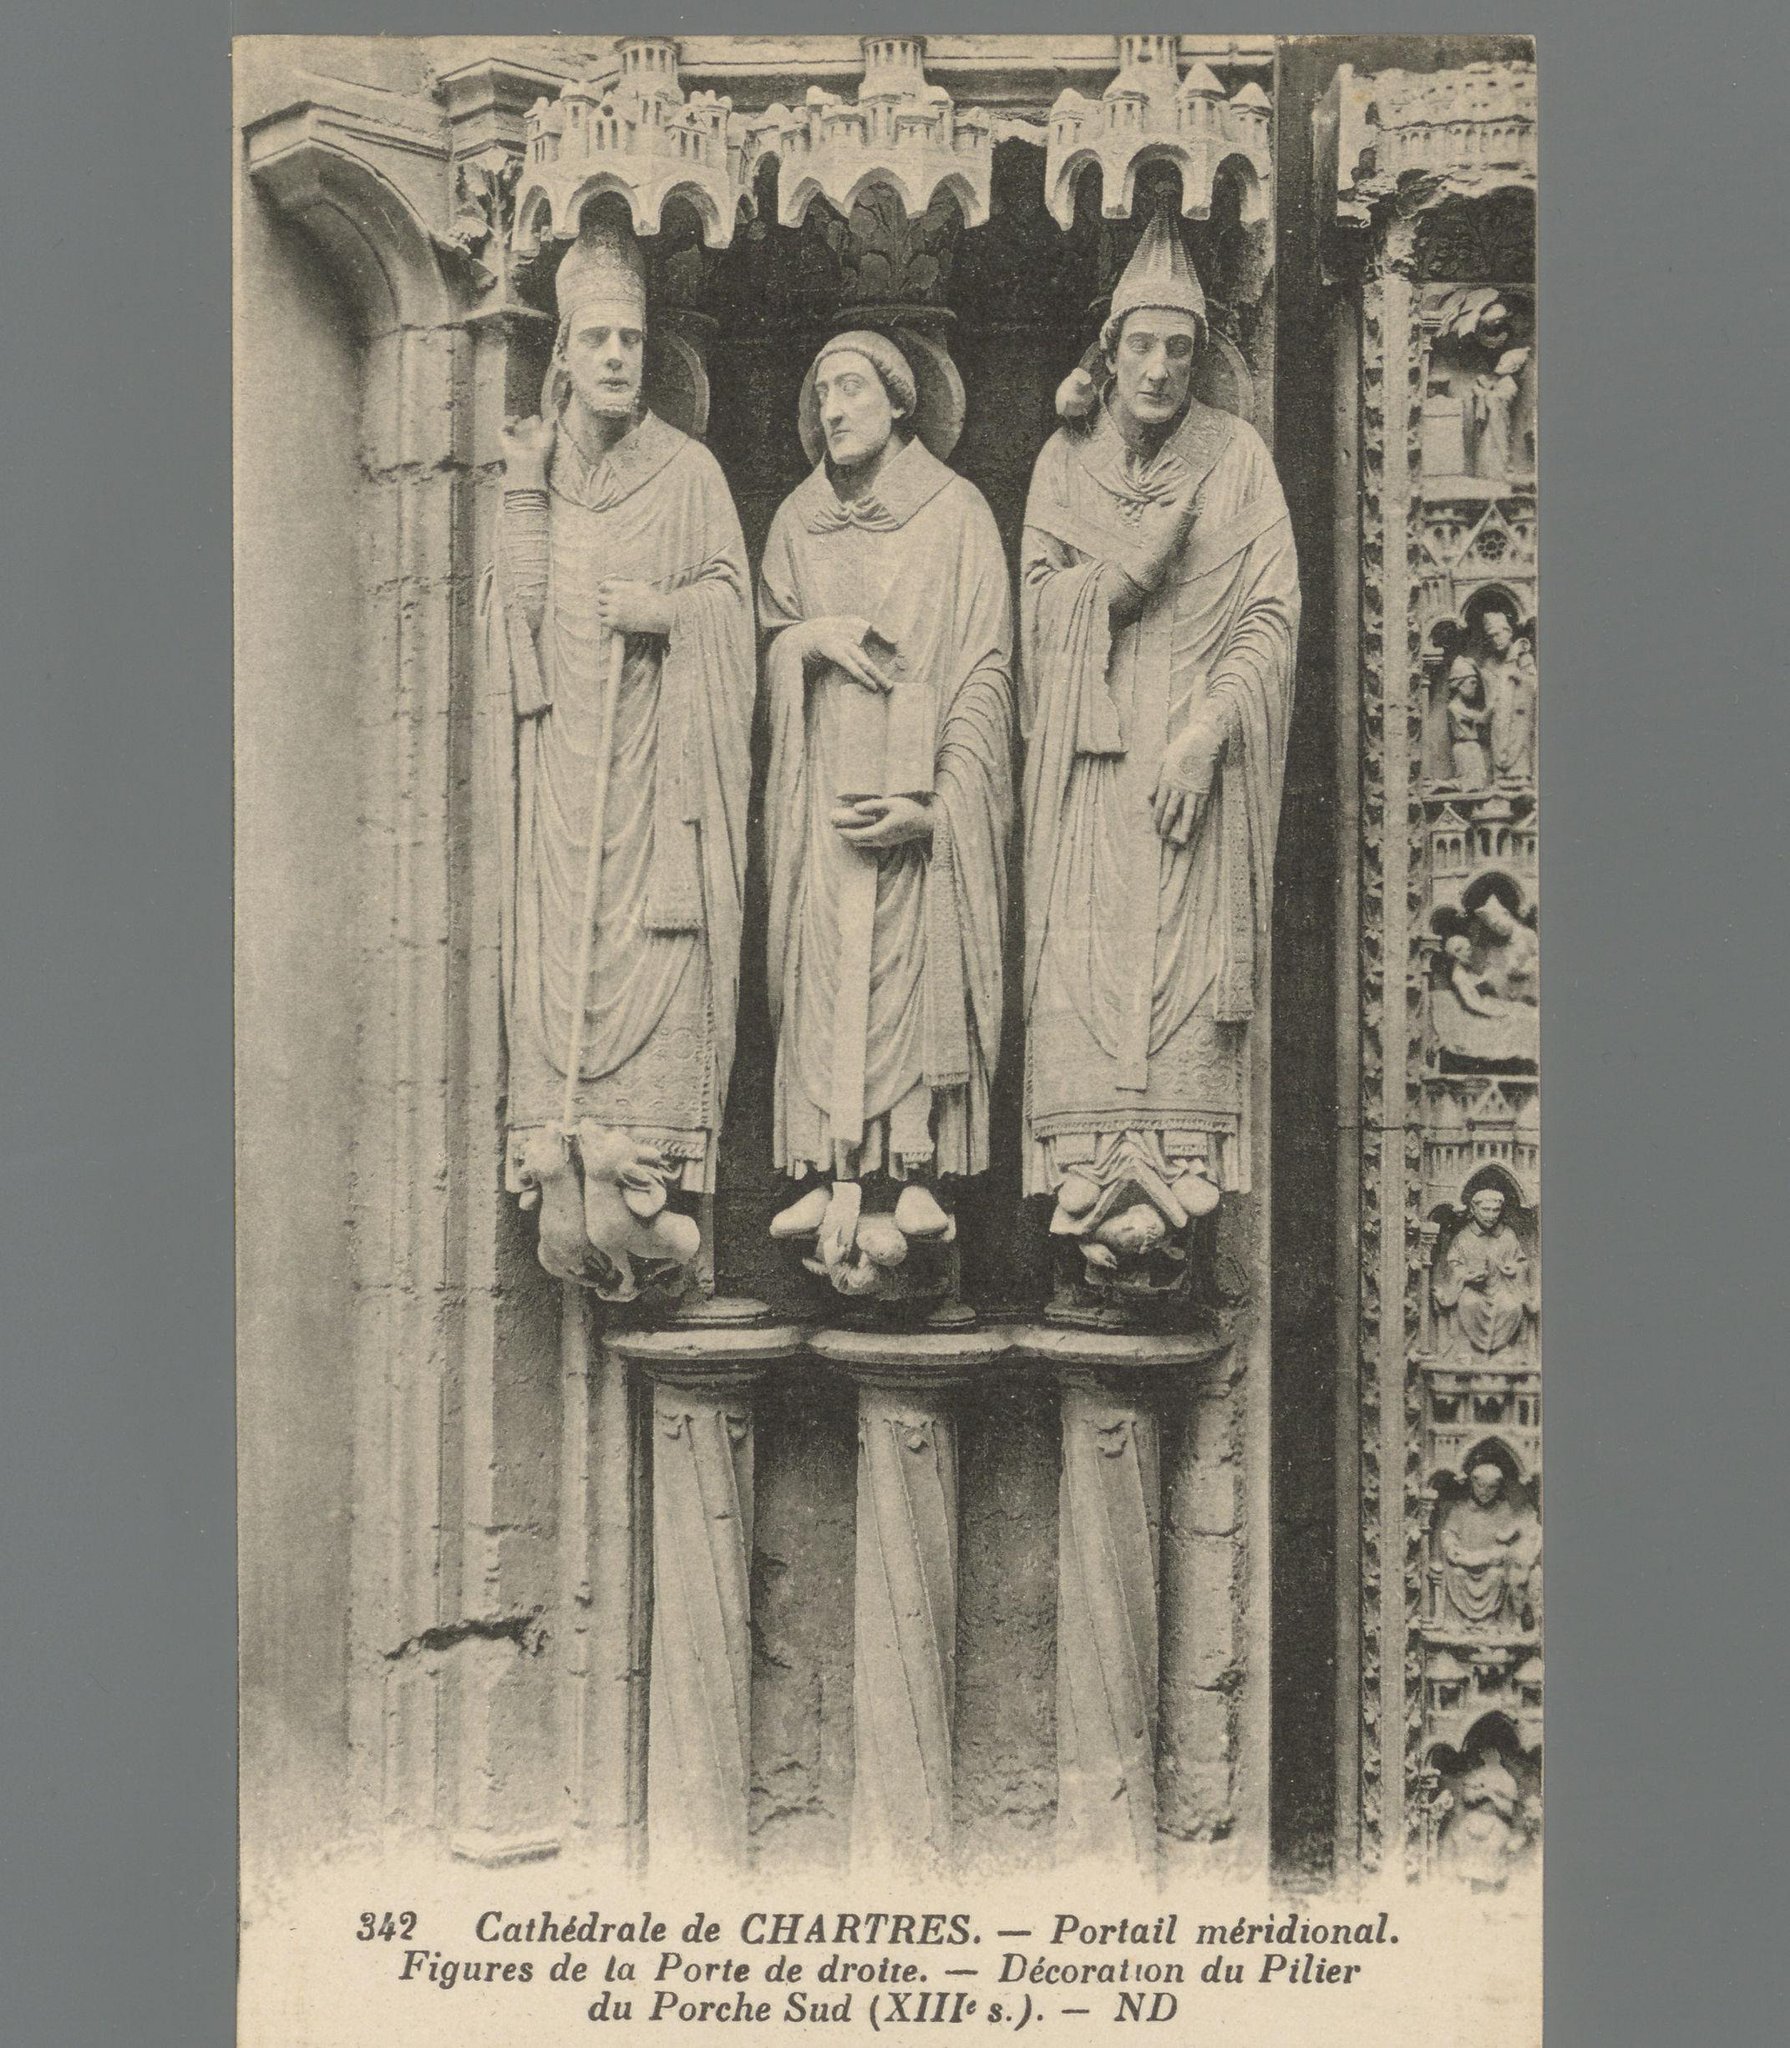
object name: photomechanical print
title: Cathédrale de Chartres. Portail méridional. Figures de la porte de droite. Décoration du pilier du porche sud (XIIIes)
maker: Anonymous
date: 1903-1932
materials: cardboard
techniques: photograph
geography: paris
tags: column, pillar ~ architecture, church (exterior)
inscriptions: collector's mark: ‘AFE v S’